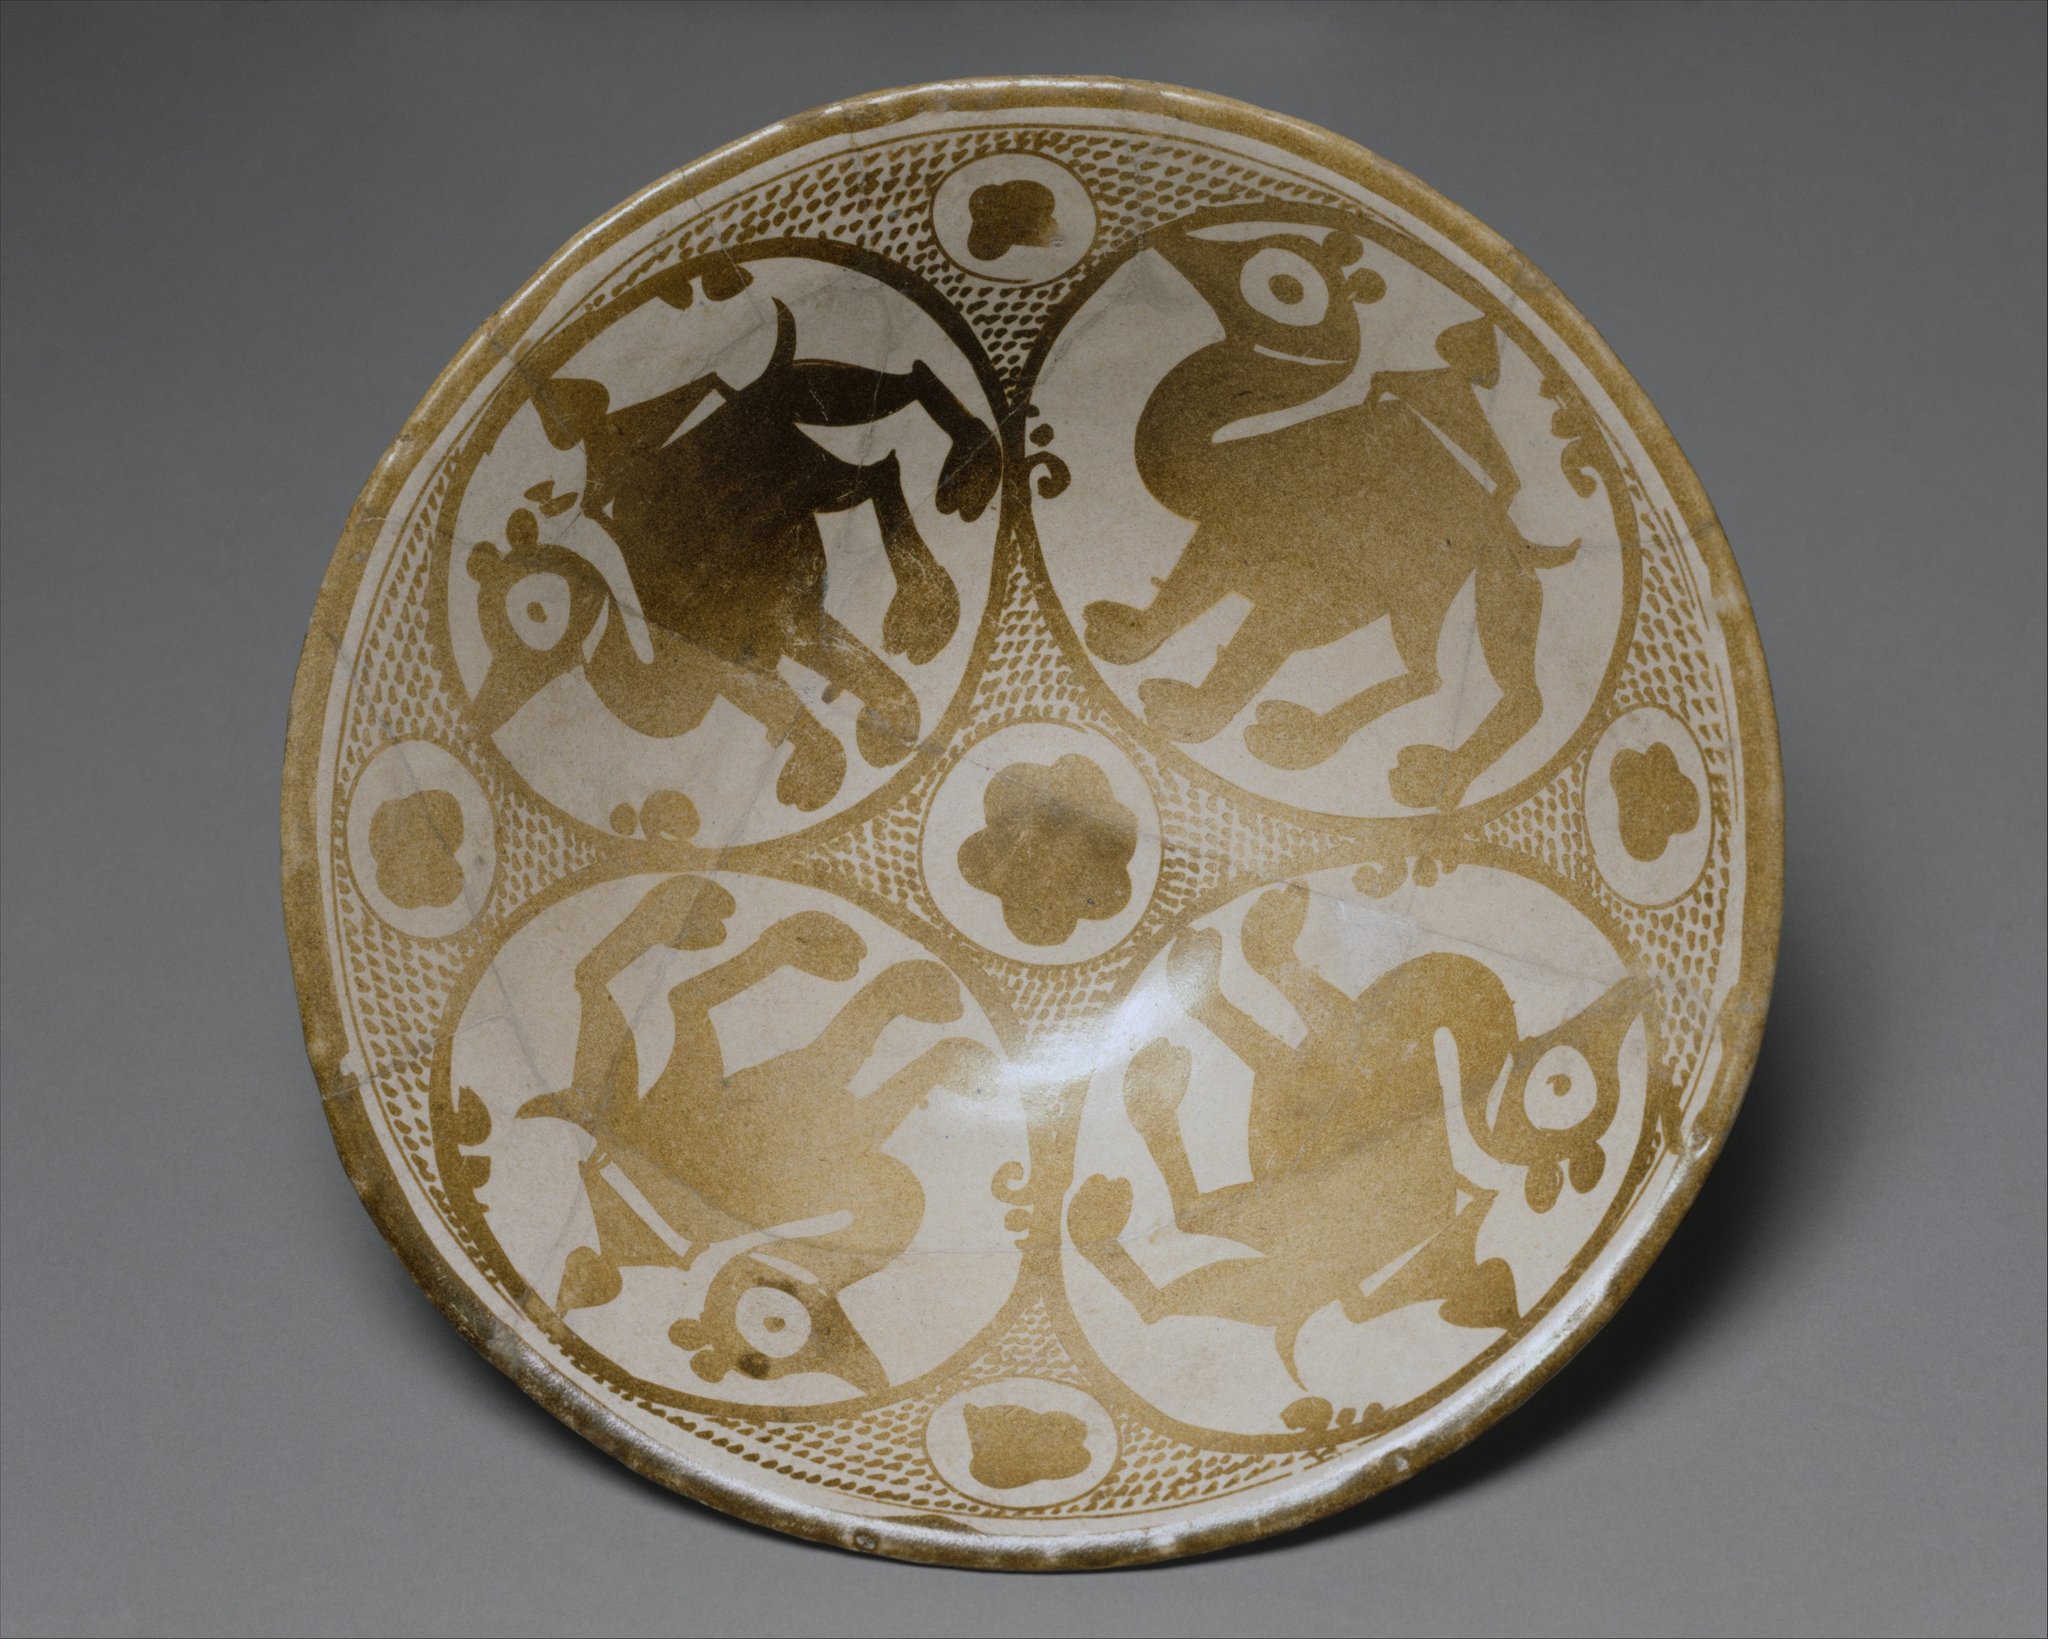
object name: bowl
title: Luster Bowl with Four Camels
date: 901-1000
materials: earthenware, glaze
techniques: luster painting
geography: iraq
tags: camels